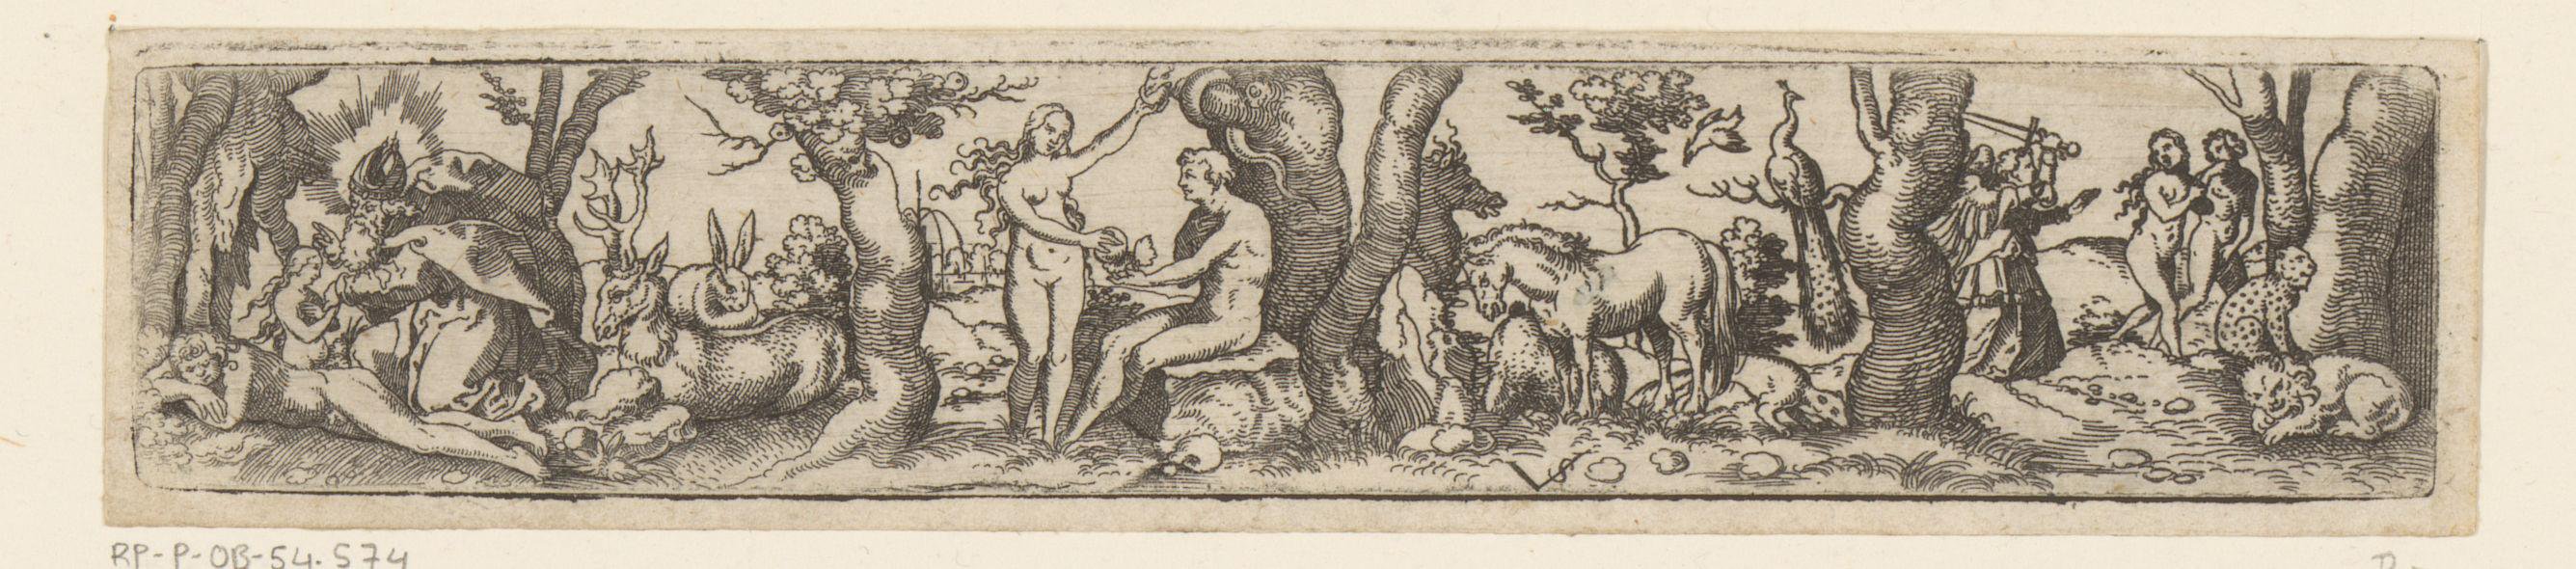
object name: print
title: Schepping van Eva, zondeval en verdrijving uit het paradijs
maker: virgilius solis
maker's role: draughtsman, print maker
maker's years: 1514-1562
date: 1524-1562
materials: paper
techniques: engraving, etching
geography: nuremberg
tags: eve offers the fruit to adam, an angel chases adam and eve out of paradise with a (flaming) sword, eve takes the fruit from the serpent (or the tree) in the presence of adam (who may be trying to stop her), eve is fashioned from adam's rib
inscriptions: number: ‘1’, collector's mark: Lugt 2228